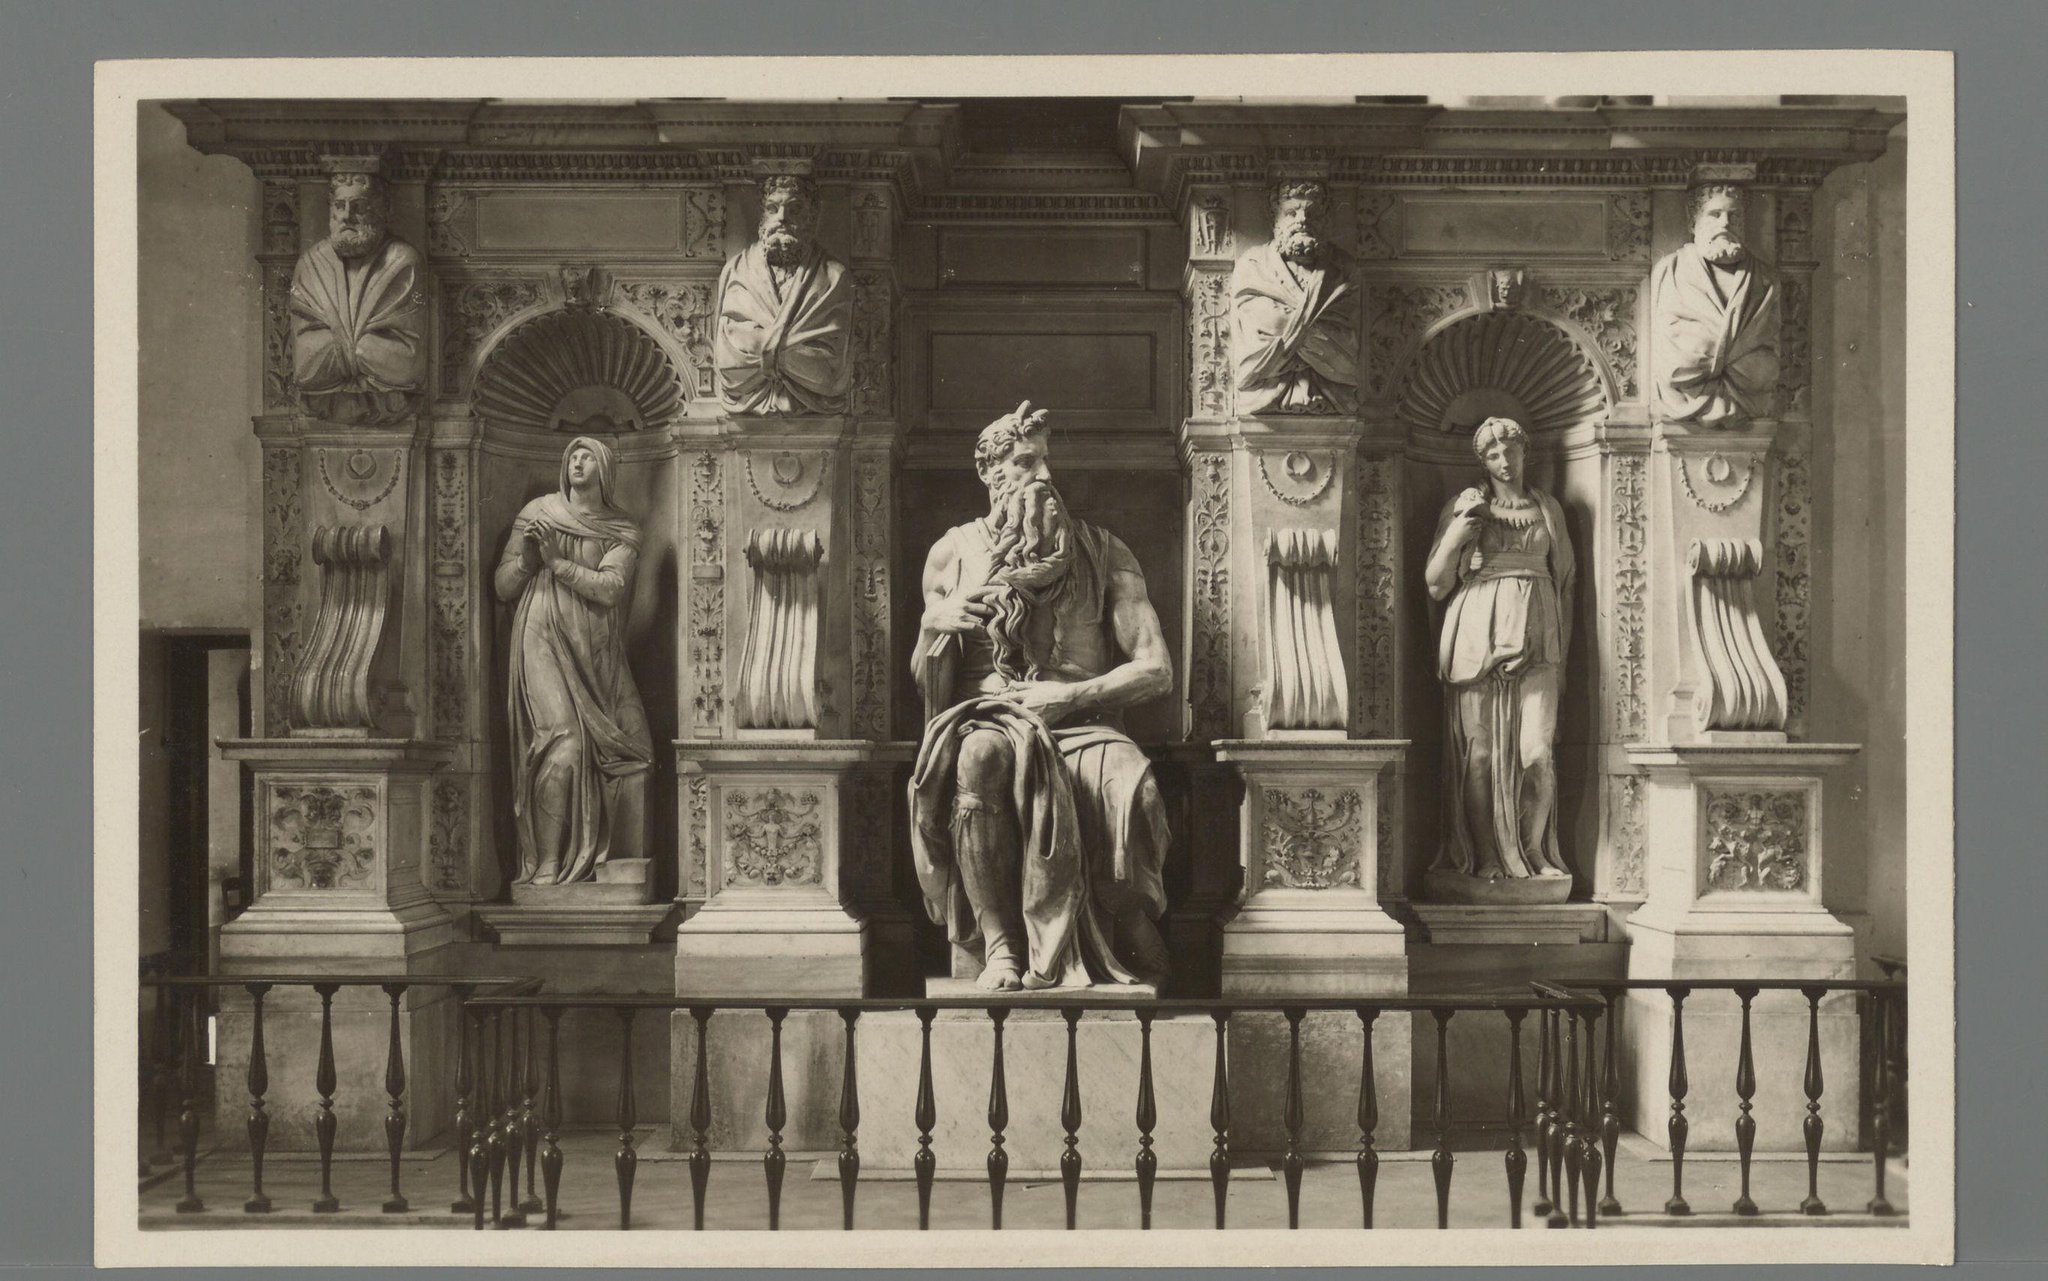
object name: photograph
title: Roma - Bass del mon. a Giulio II nella Chiesa di S. Pietro in Vincoli (Michelangelo)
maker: Anonymous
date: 1906-1930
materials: paper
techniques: gelatin silver print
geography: rome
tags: church (exterior), statues, paintings, etc. ~ objects of worship in roman religion, rome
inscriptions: collector's mark: ‘AFE v S’